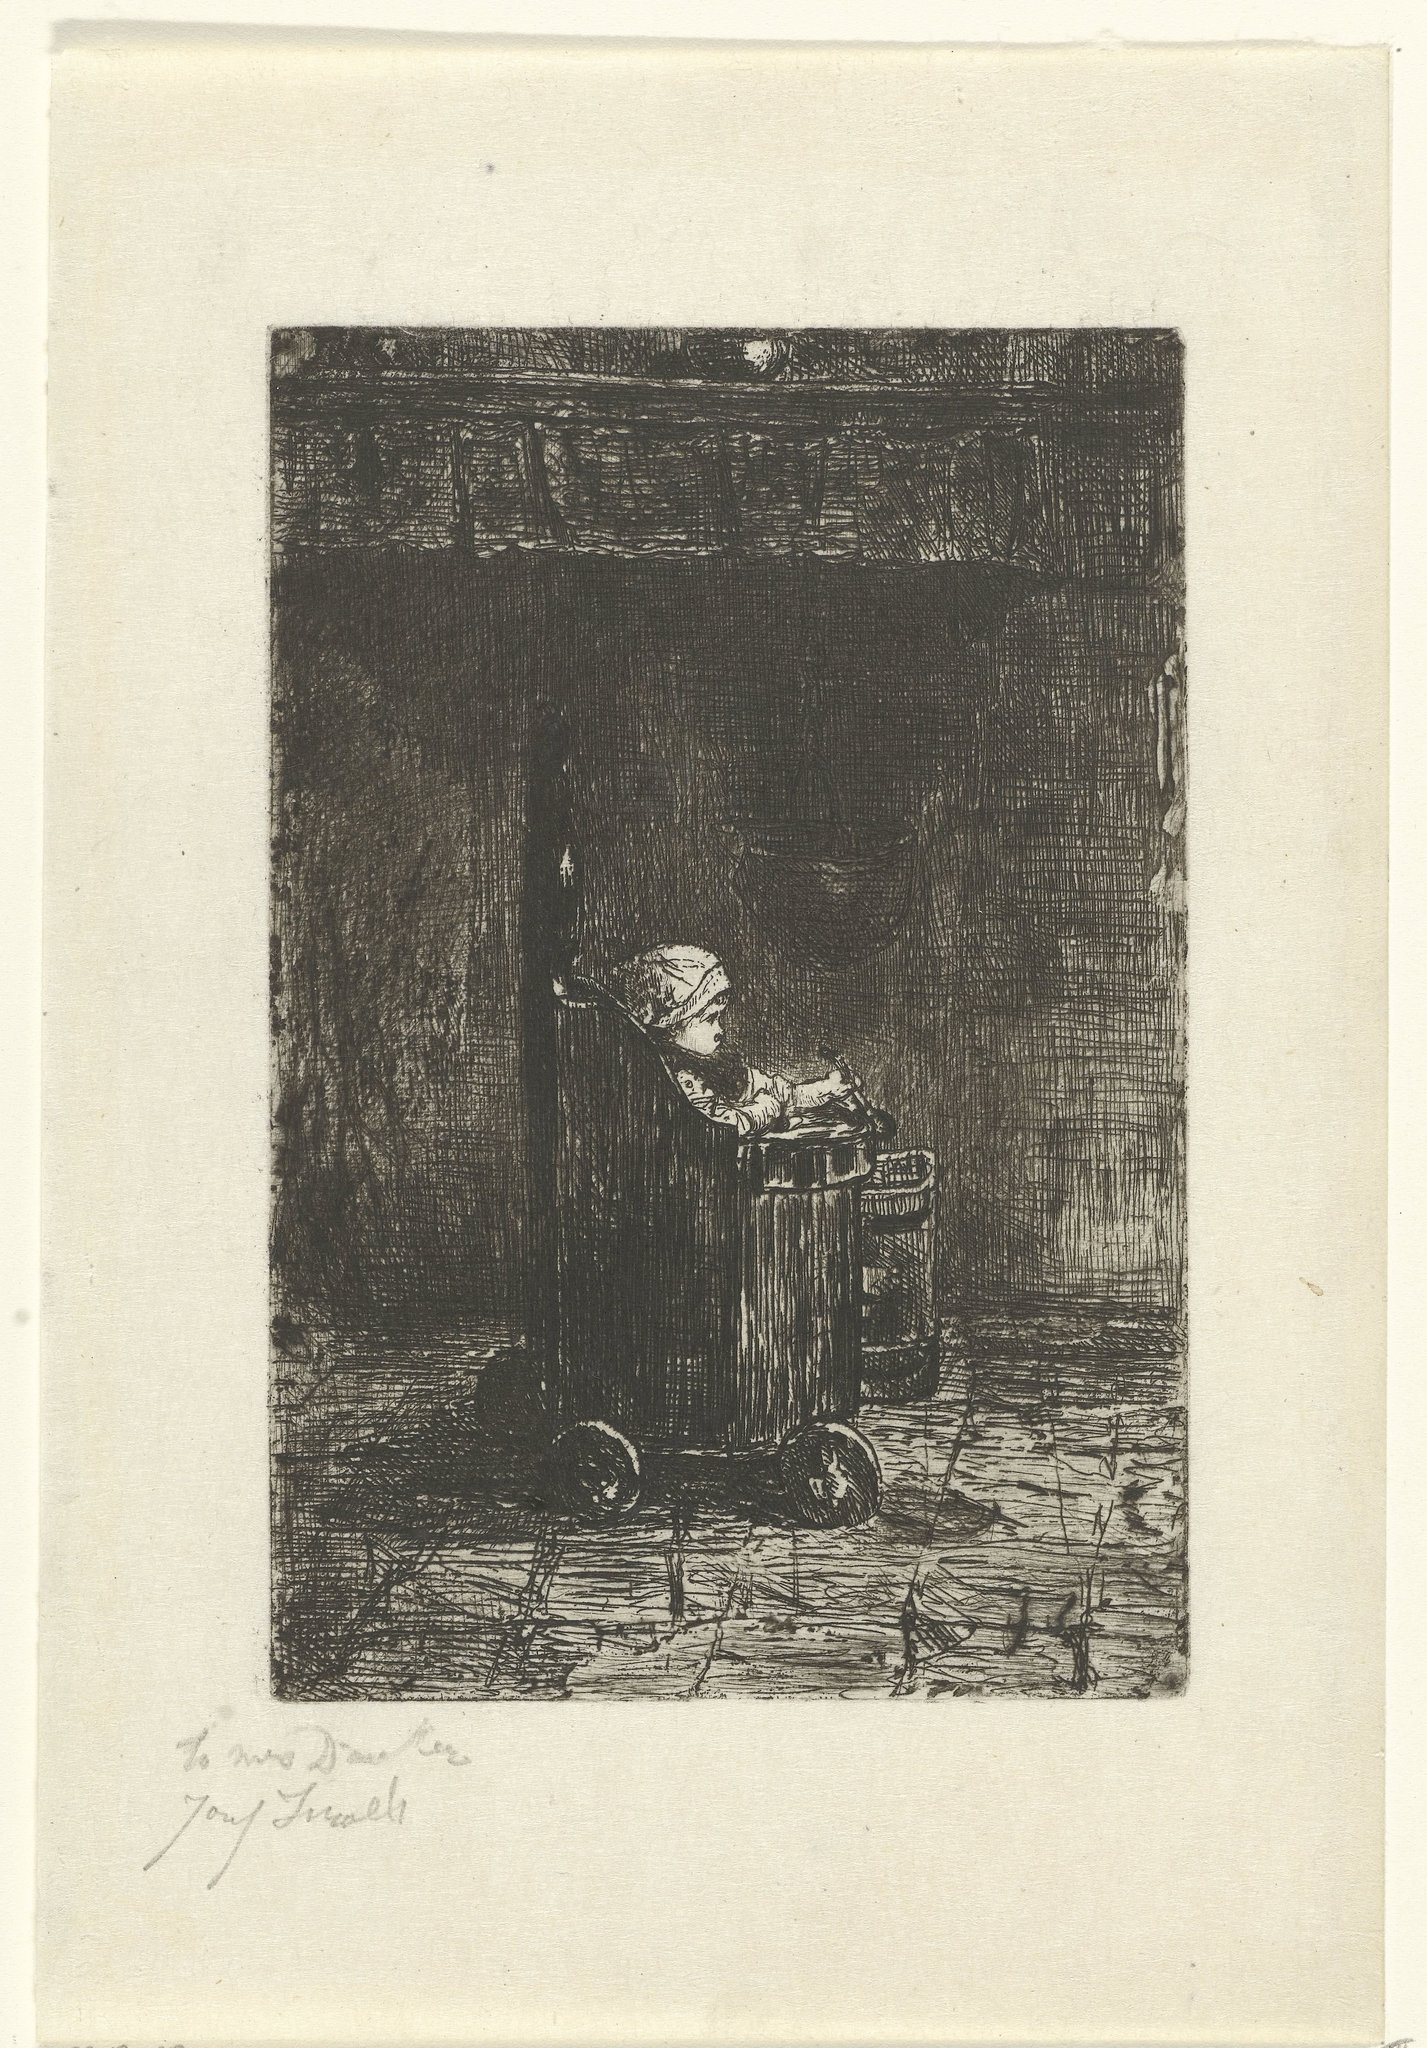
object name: print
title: Kind in de kinderstoel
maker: jozef israëls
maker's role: draughtsman, painter, print maker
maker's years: 1824-1911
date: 1835-1911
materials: paper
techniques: etching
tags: baby-chair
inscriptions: collector's mark: Lugt 2228, signature: ‘to mrs [...] Jozef Israels’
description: Een kind in een houten kinderstoel op wielen bij de schoorsteen.